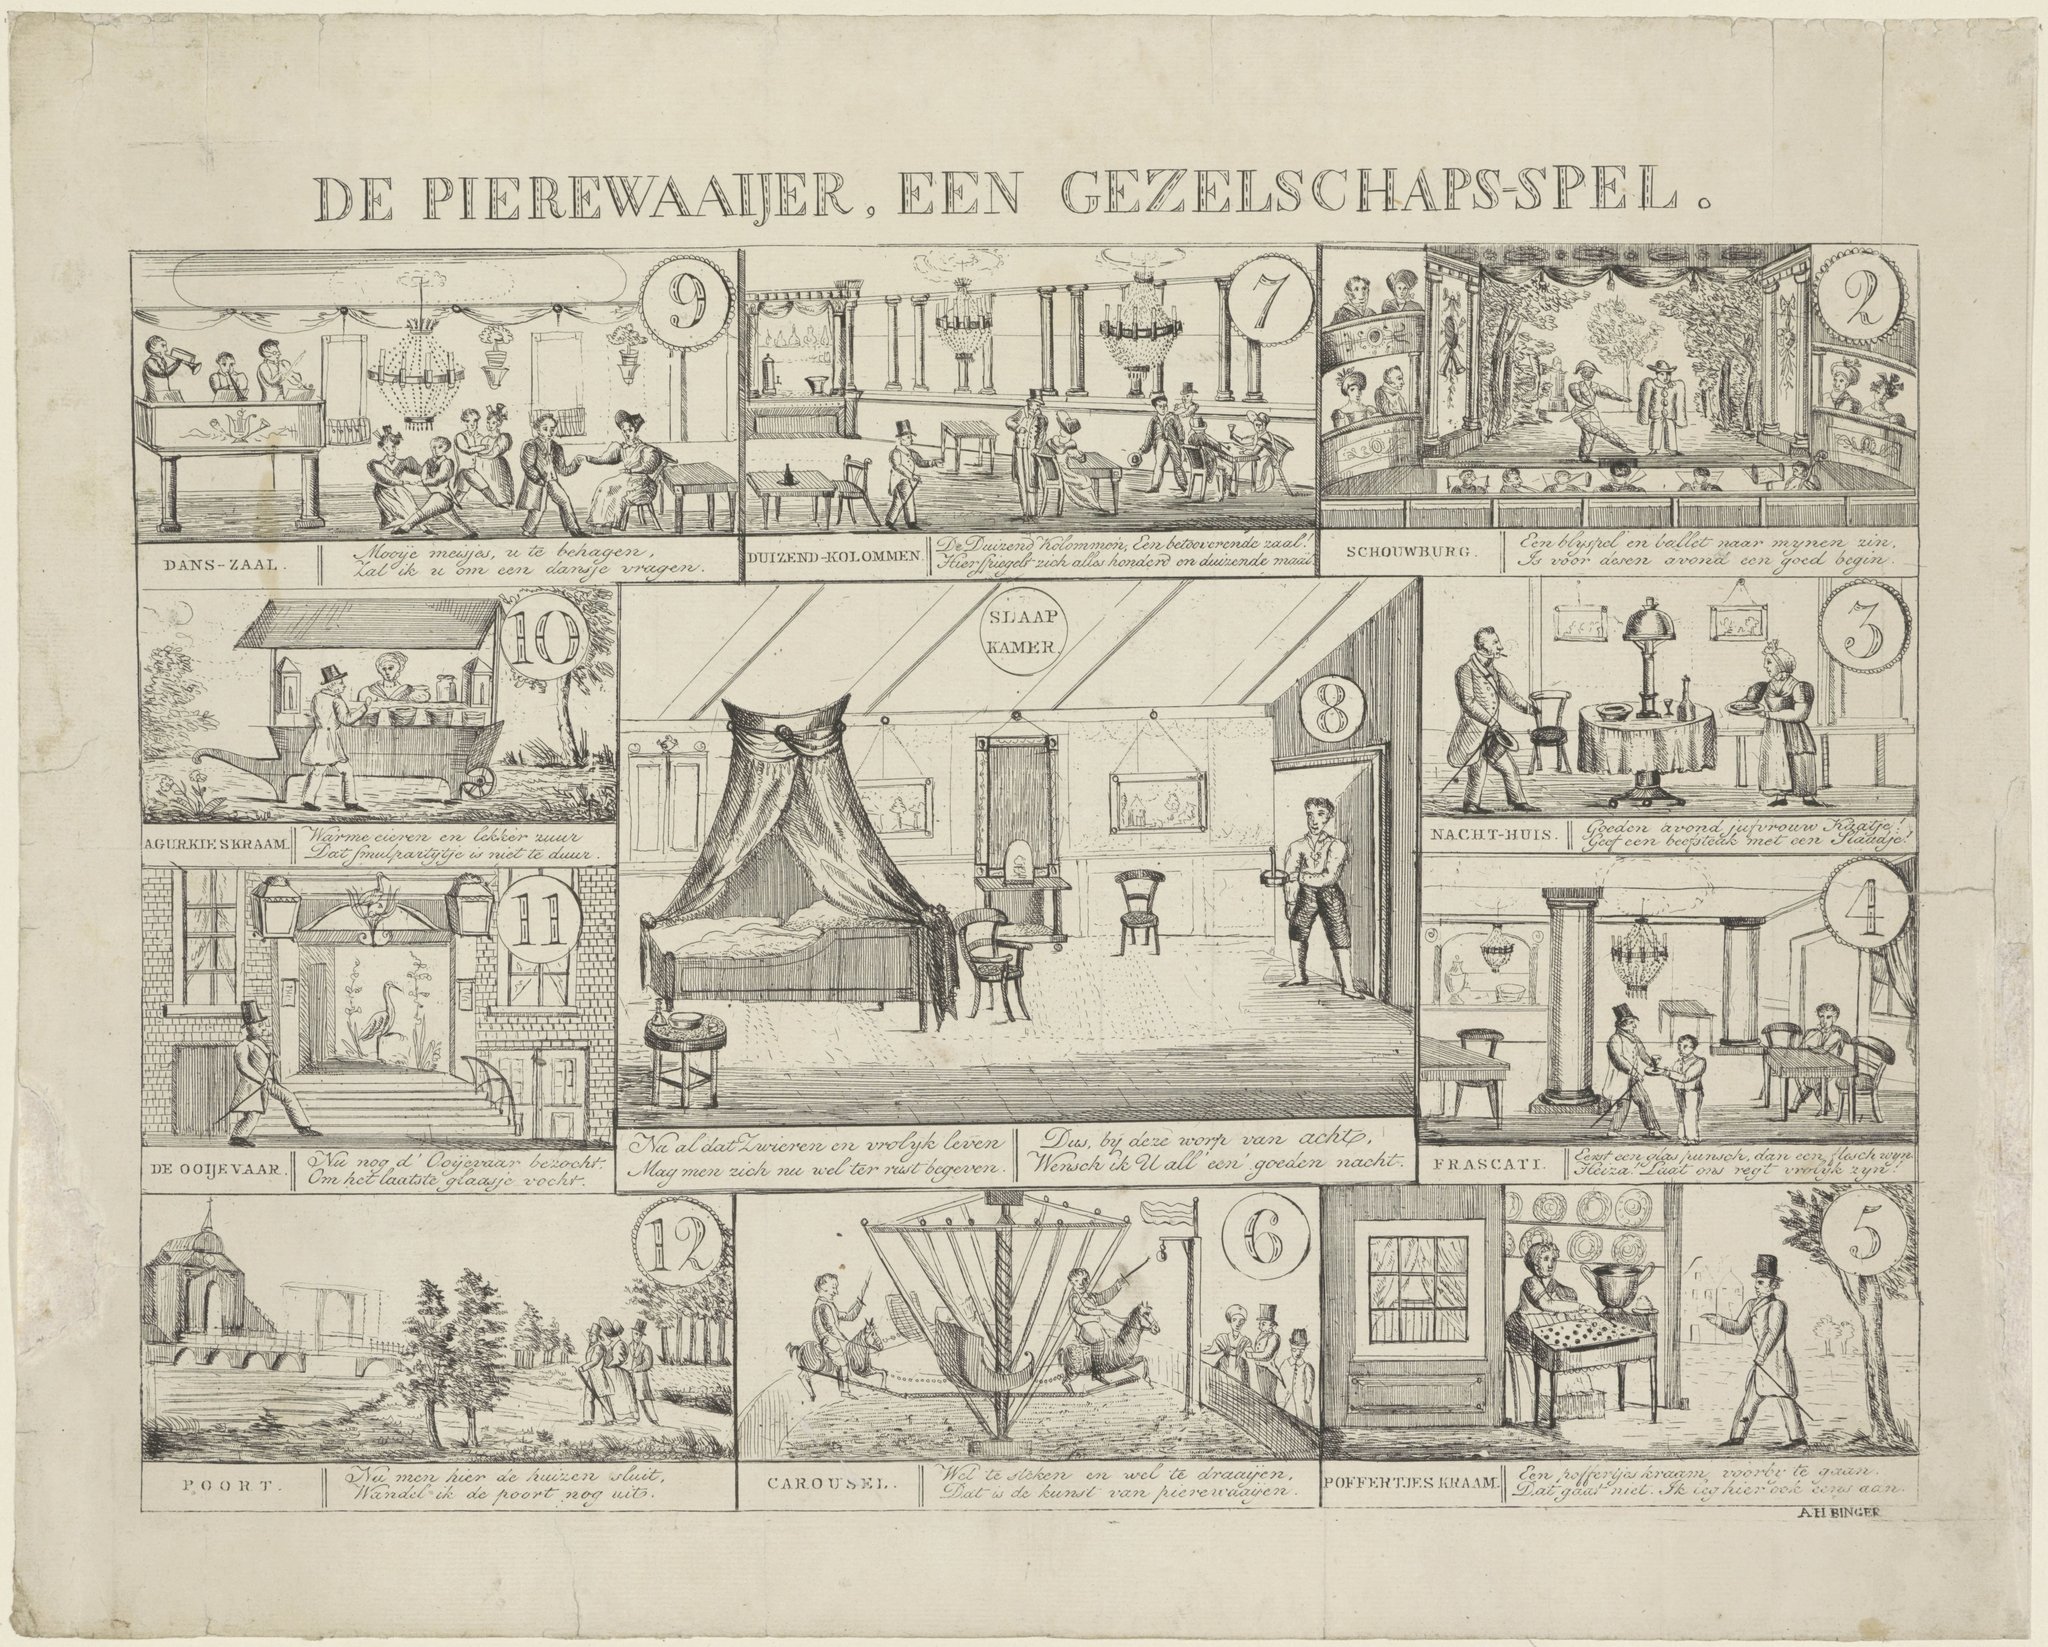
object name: print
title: De Pierewaaijer, een gezelschaps-spel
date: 1816-1897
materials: paper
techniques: etching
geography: netherlands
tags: board-games of chance, theatre, theatrical performance, board-games, bedroom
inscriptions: collector's mark: Lugt 2760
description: Bordspel met vakjes genummerd van 2 tot en met 12, dat een pierewaaier (feestganger) volgt op een stapavond in Amsterdam. Hij bezoekt onder andere een danszaal, de schouwburg Frascati, de kermis, een poffertjeskraam, café de Duizend Kolommen en de Ooijevaar. Boven de voorstelling de titel.